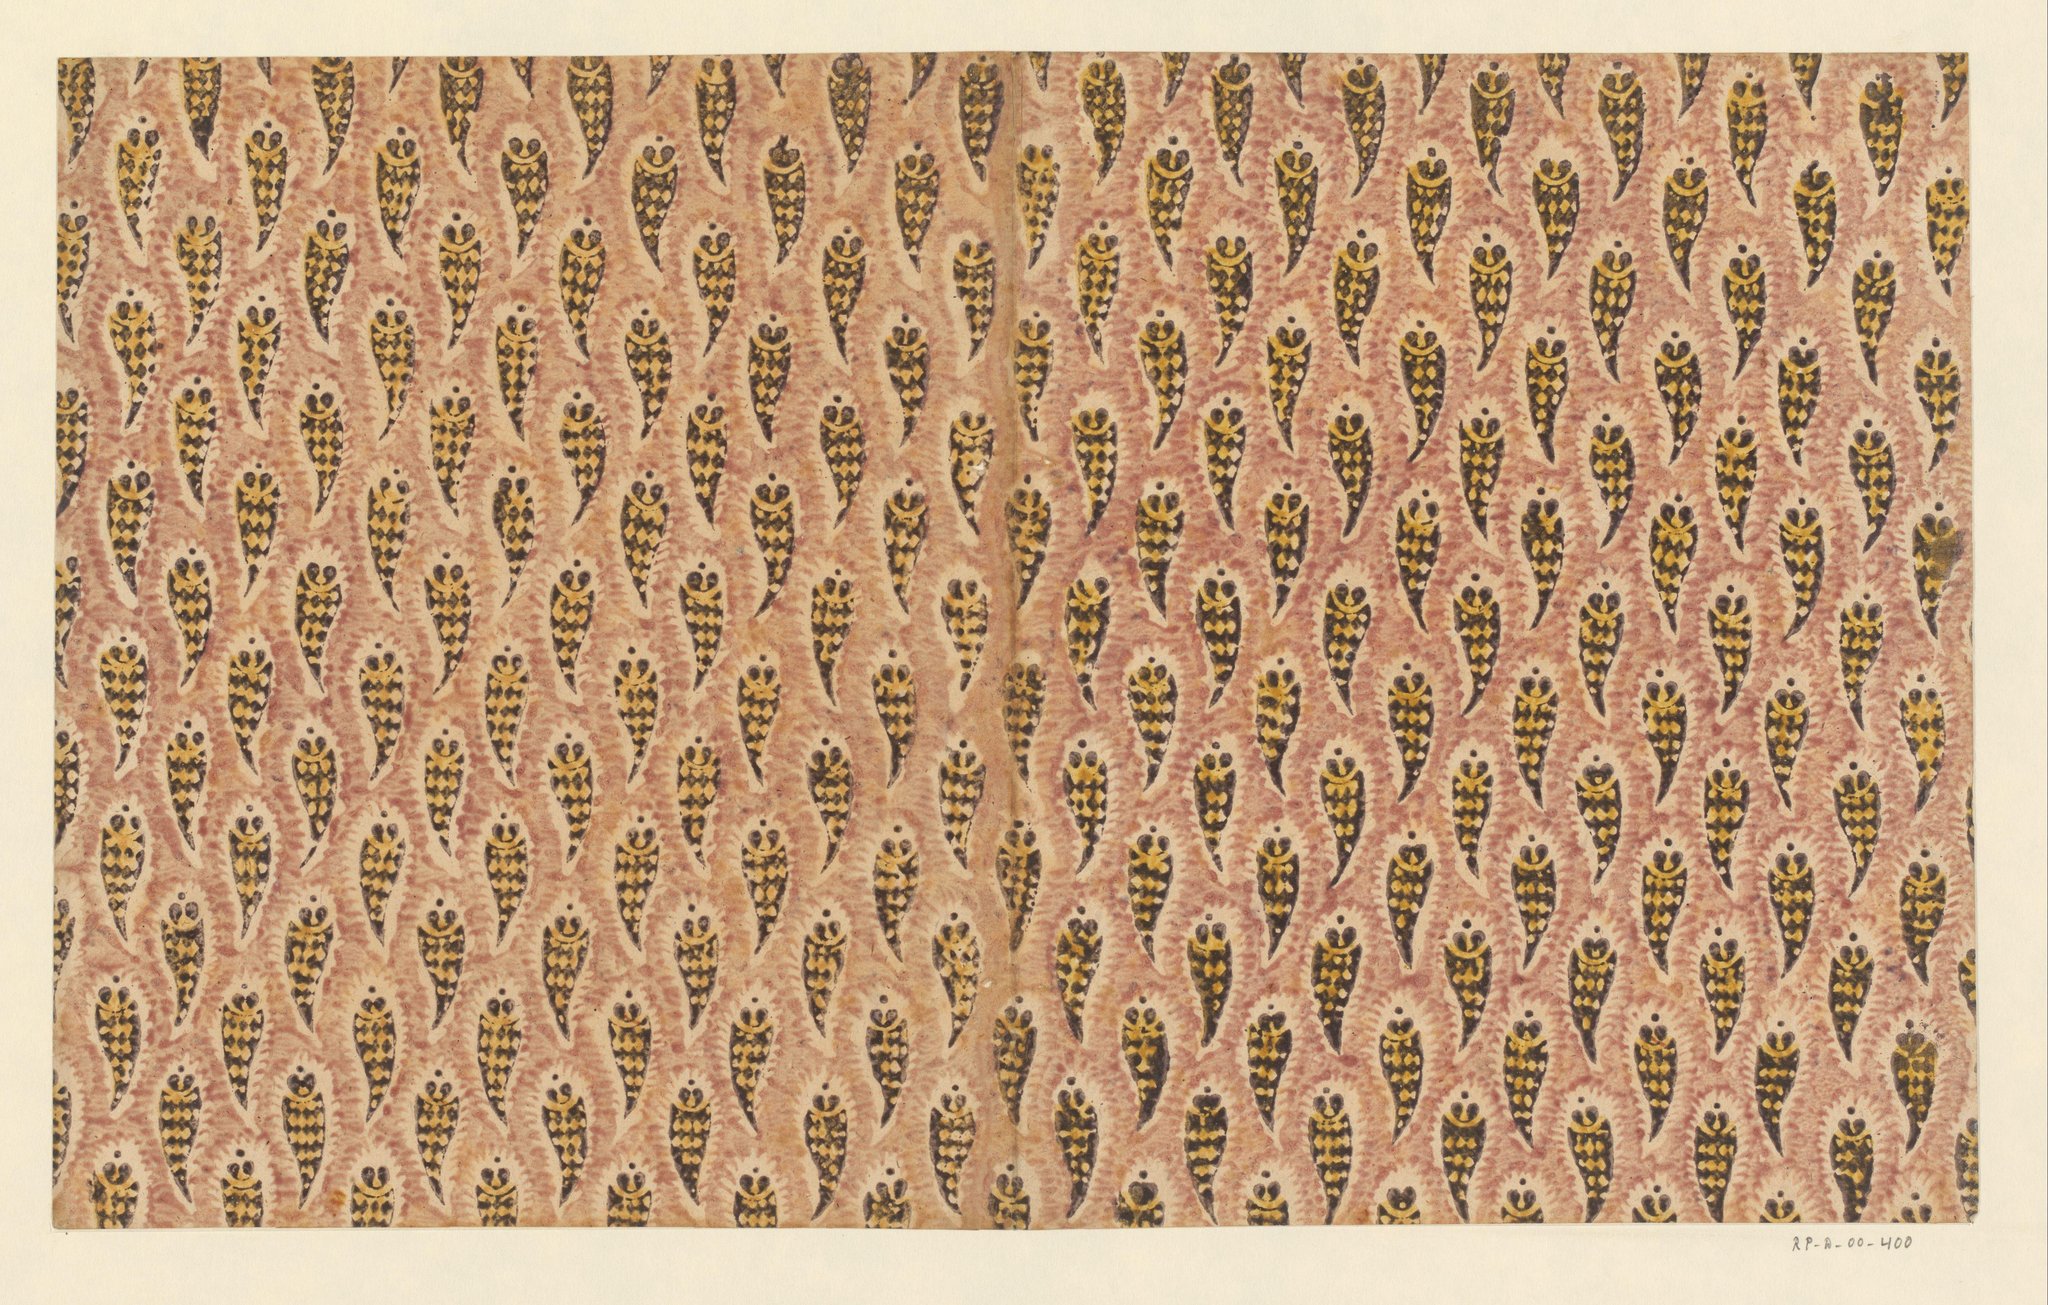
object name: wrapper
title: Blad met strooipatroon van uitgespaard bladvormig motief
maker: Anonymous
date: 1700-1850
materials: paper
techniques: printing block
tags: fantasy ornament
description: Blad met strooipatroon van een uitgespaard bladvormig Paisley motief. Gebruikt als omslag.